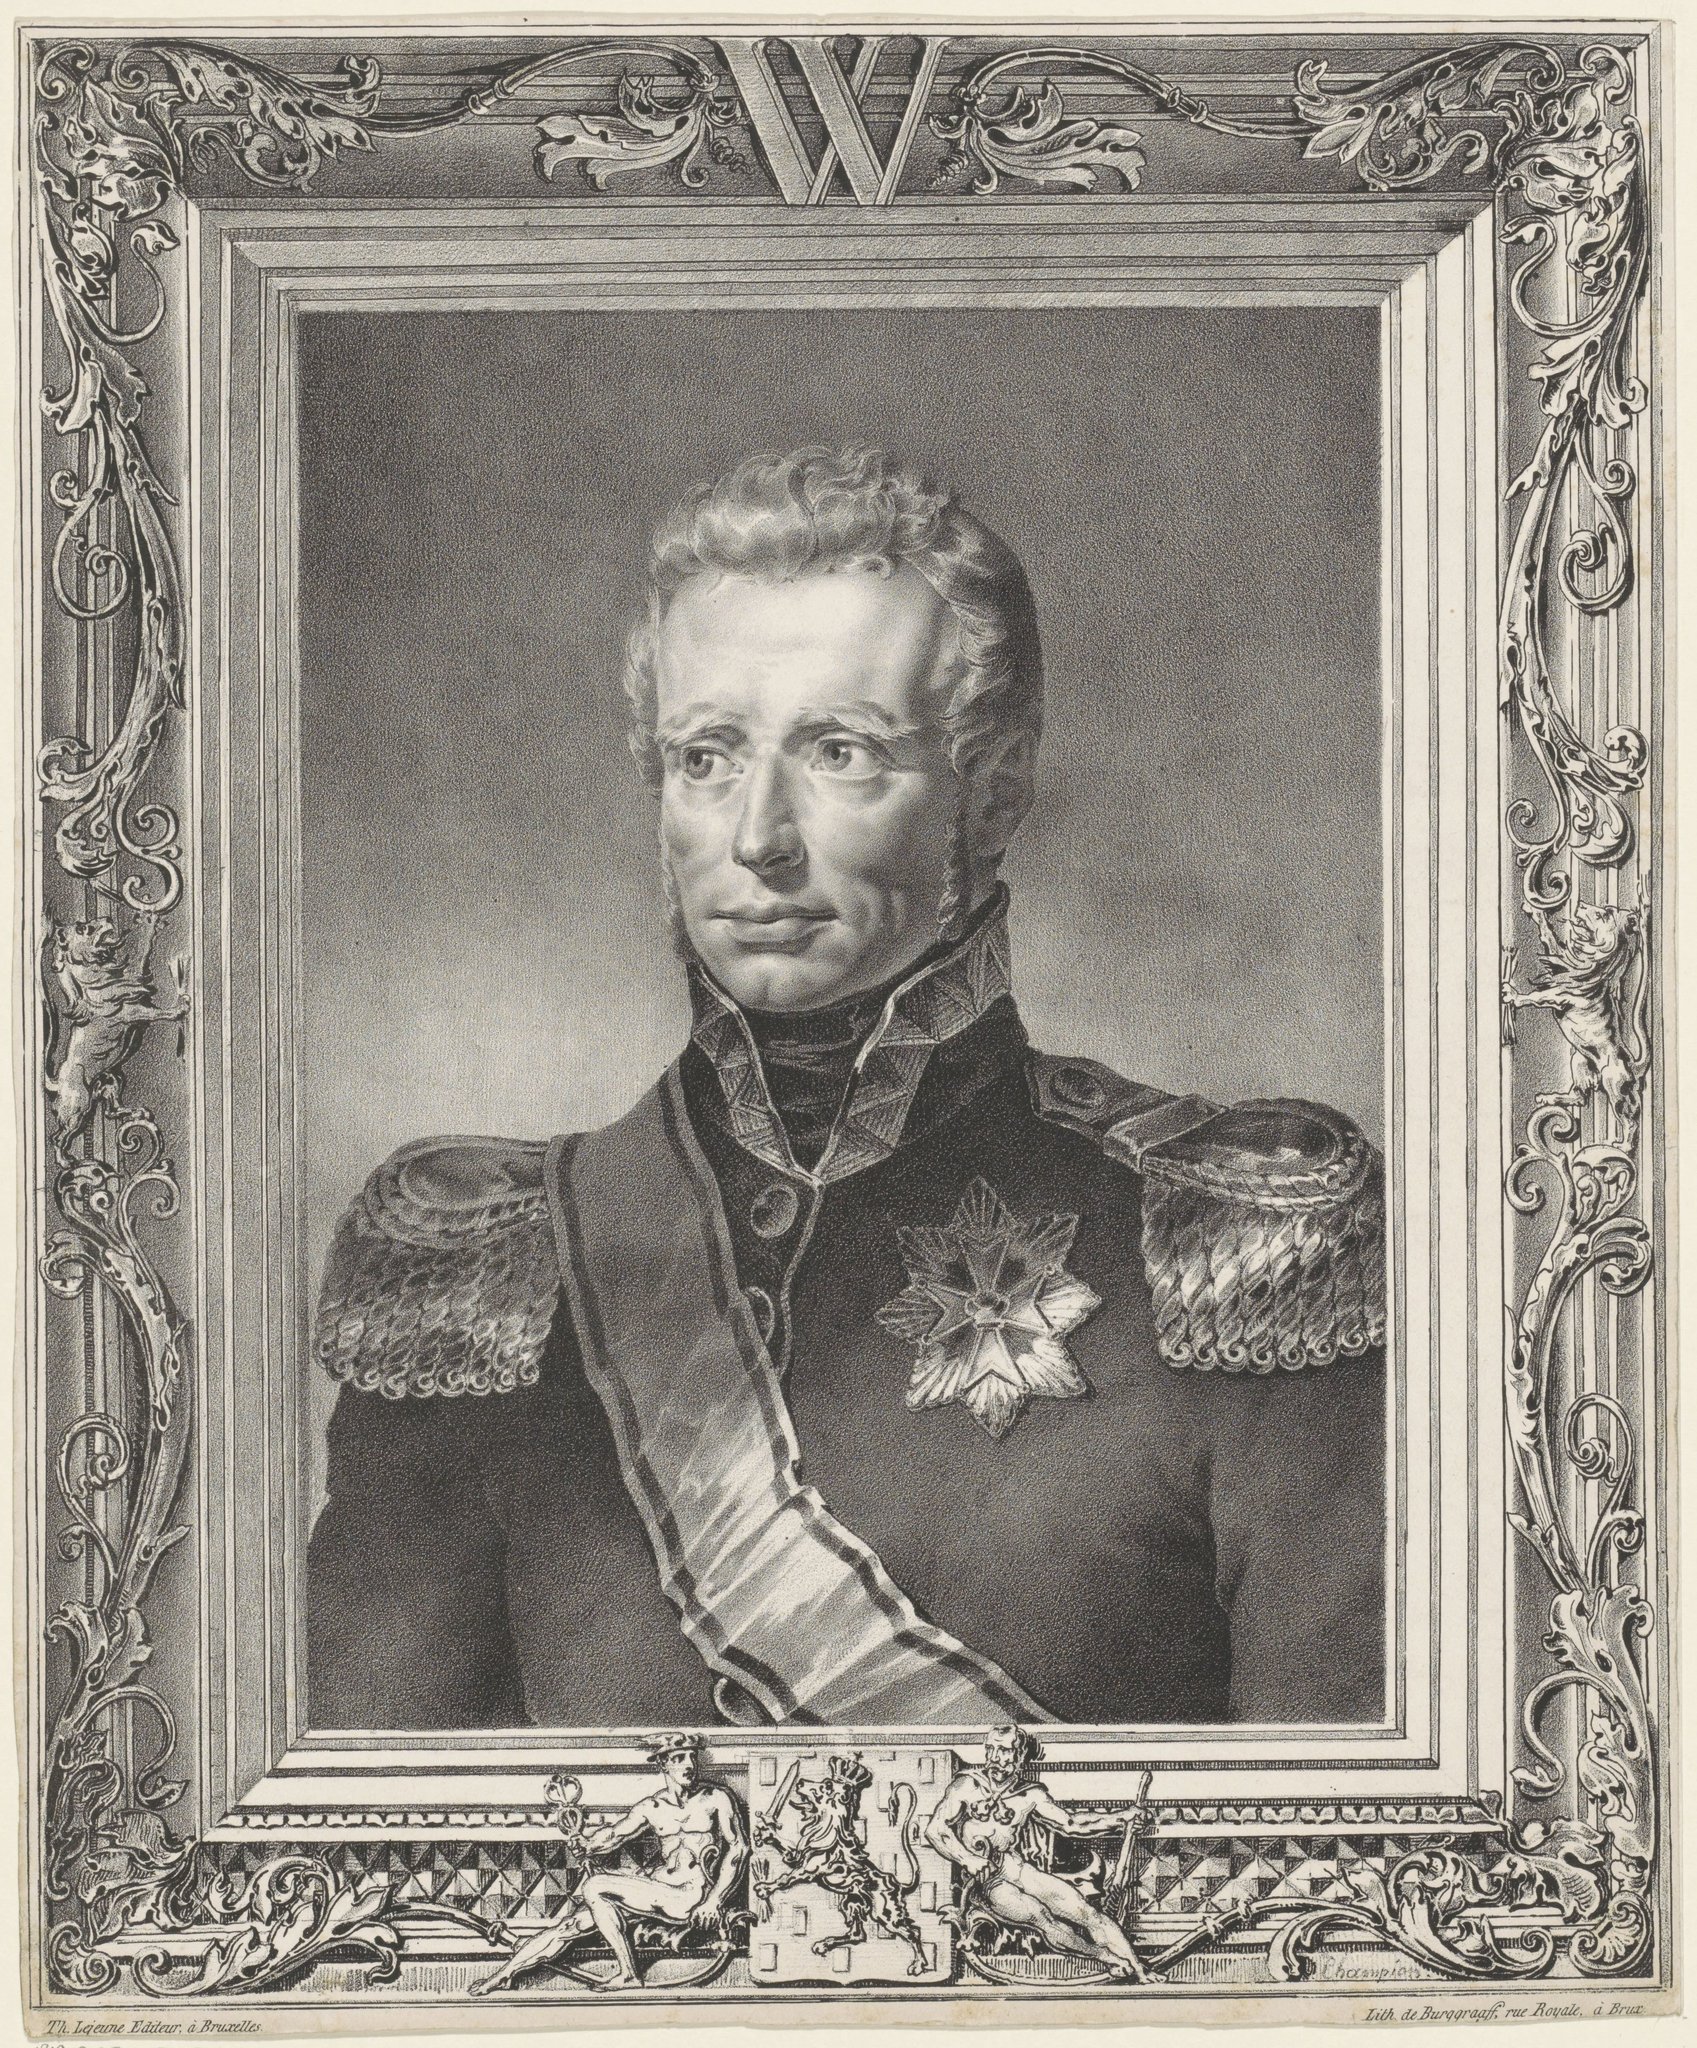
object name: print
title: Portret van Willem I Frederik, koning der Nederlanden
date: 1815-1830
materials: paper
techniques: lithograph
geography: brussels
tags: the hague, berlin, william i of the netherlands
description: De hier vermelde titel verwijst naar de hoogst verkregen titel van de geportretteerde, niet per se naar de titel die de geportretteerde op deze voorstelling draagt.